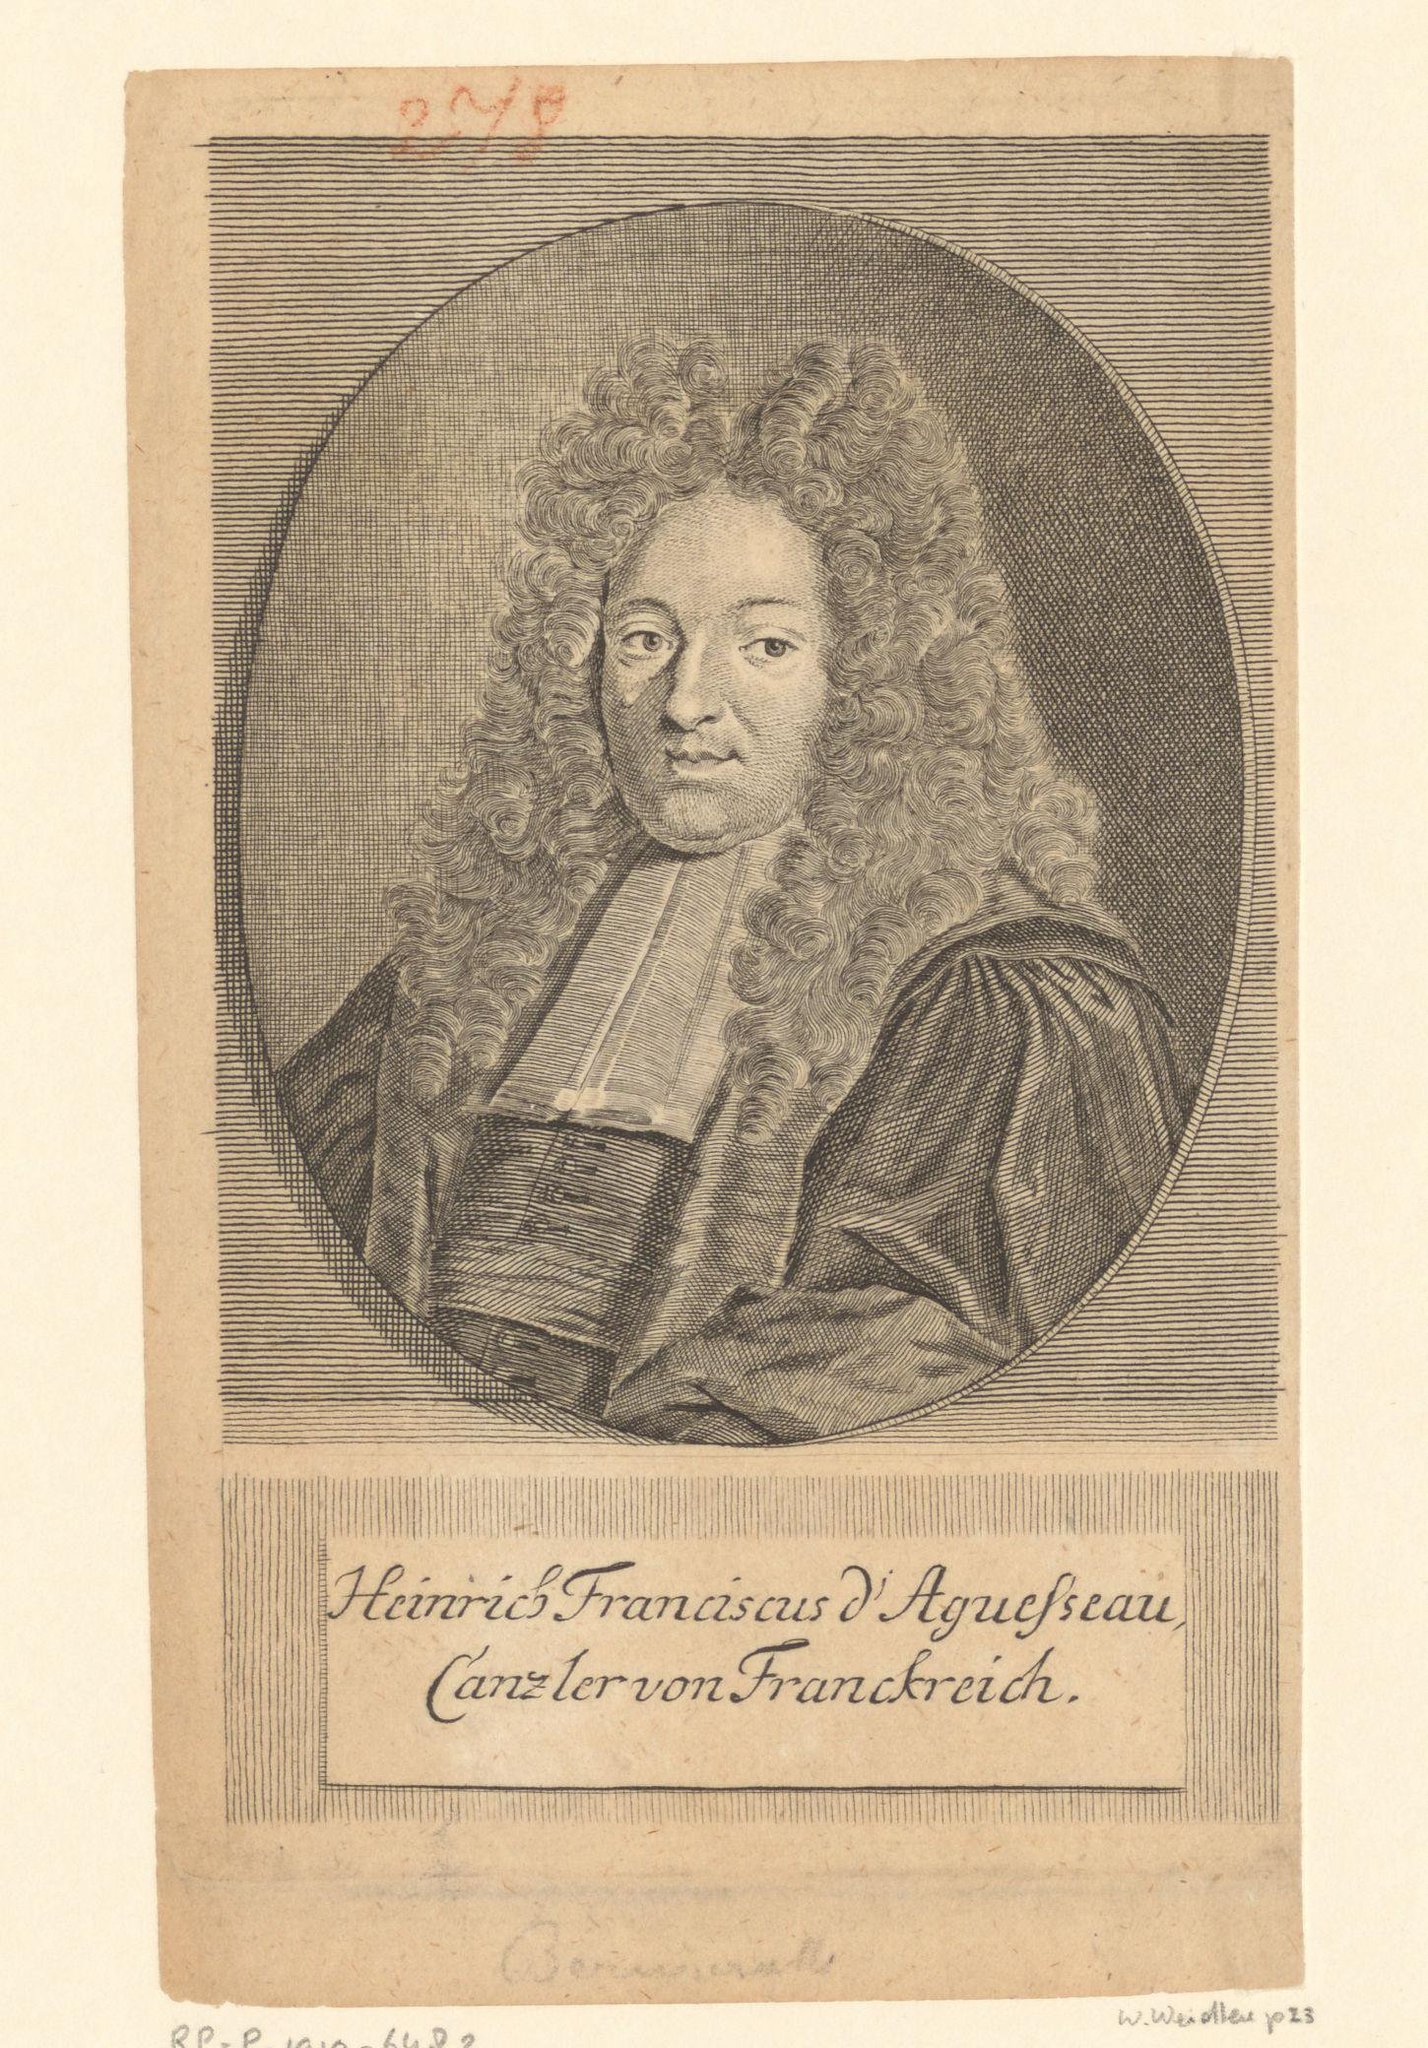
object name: print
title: Portret van Henri François d'Aguesseau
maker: martin bernigeroth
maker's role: print maker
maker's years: 1670-1733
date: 1727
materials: paper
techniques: engraving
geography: leipzig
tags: paris, historical persons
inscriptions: collector's mark: Lugt 2228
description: Prent ook gebruikt in: Die Europäische Fama, Welche den gegenwärtigen Zustand der vornehmsten Höfe entdecket. dl. 305. Leipzig: Gleditsch, 1727.